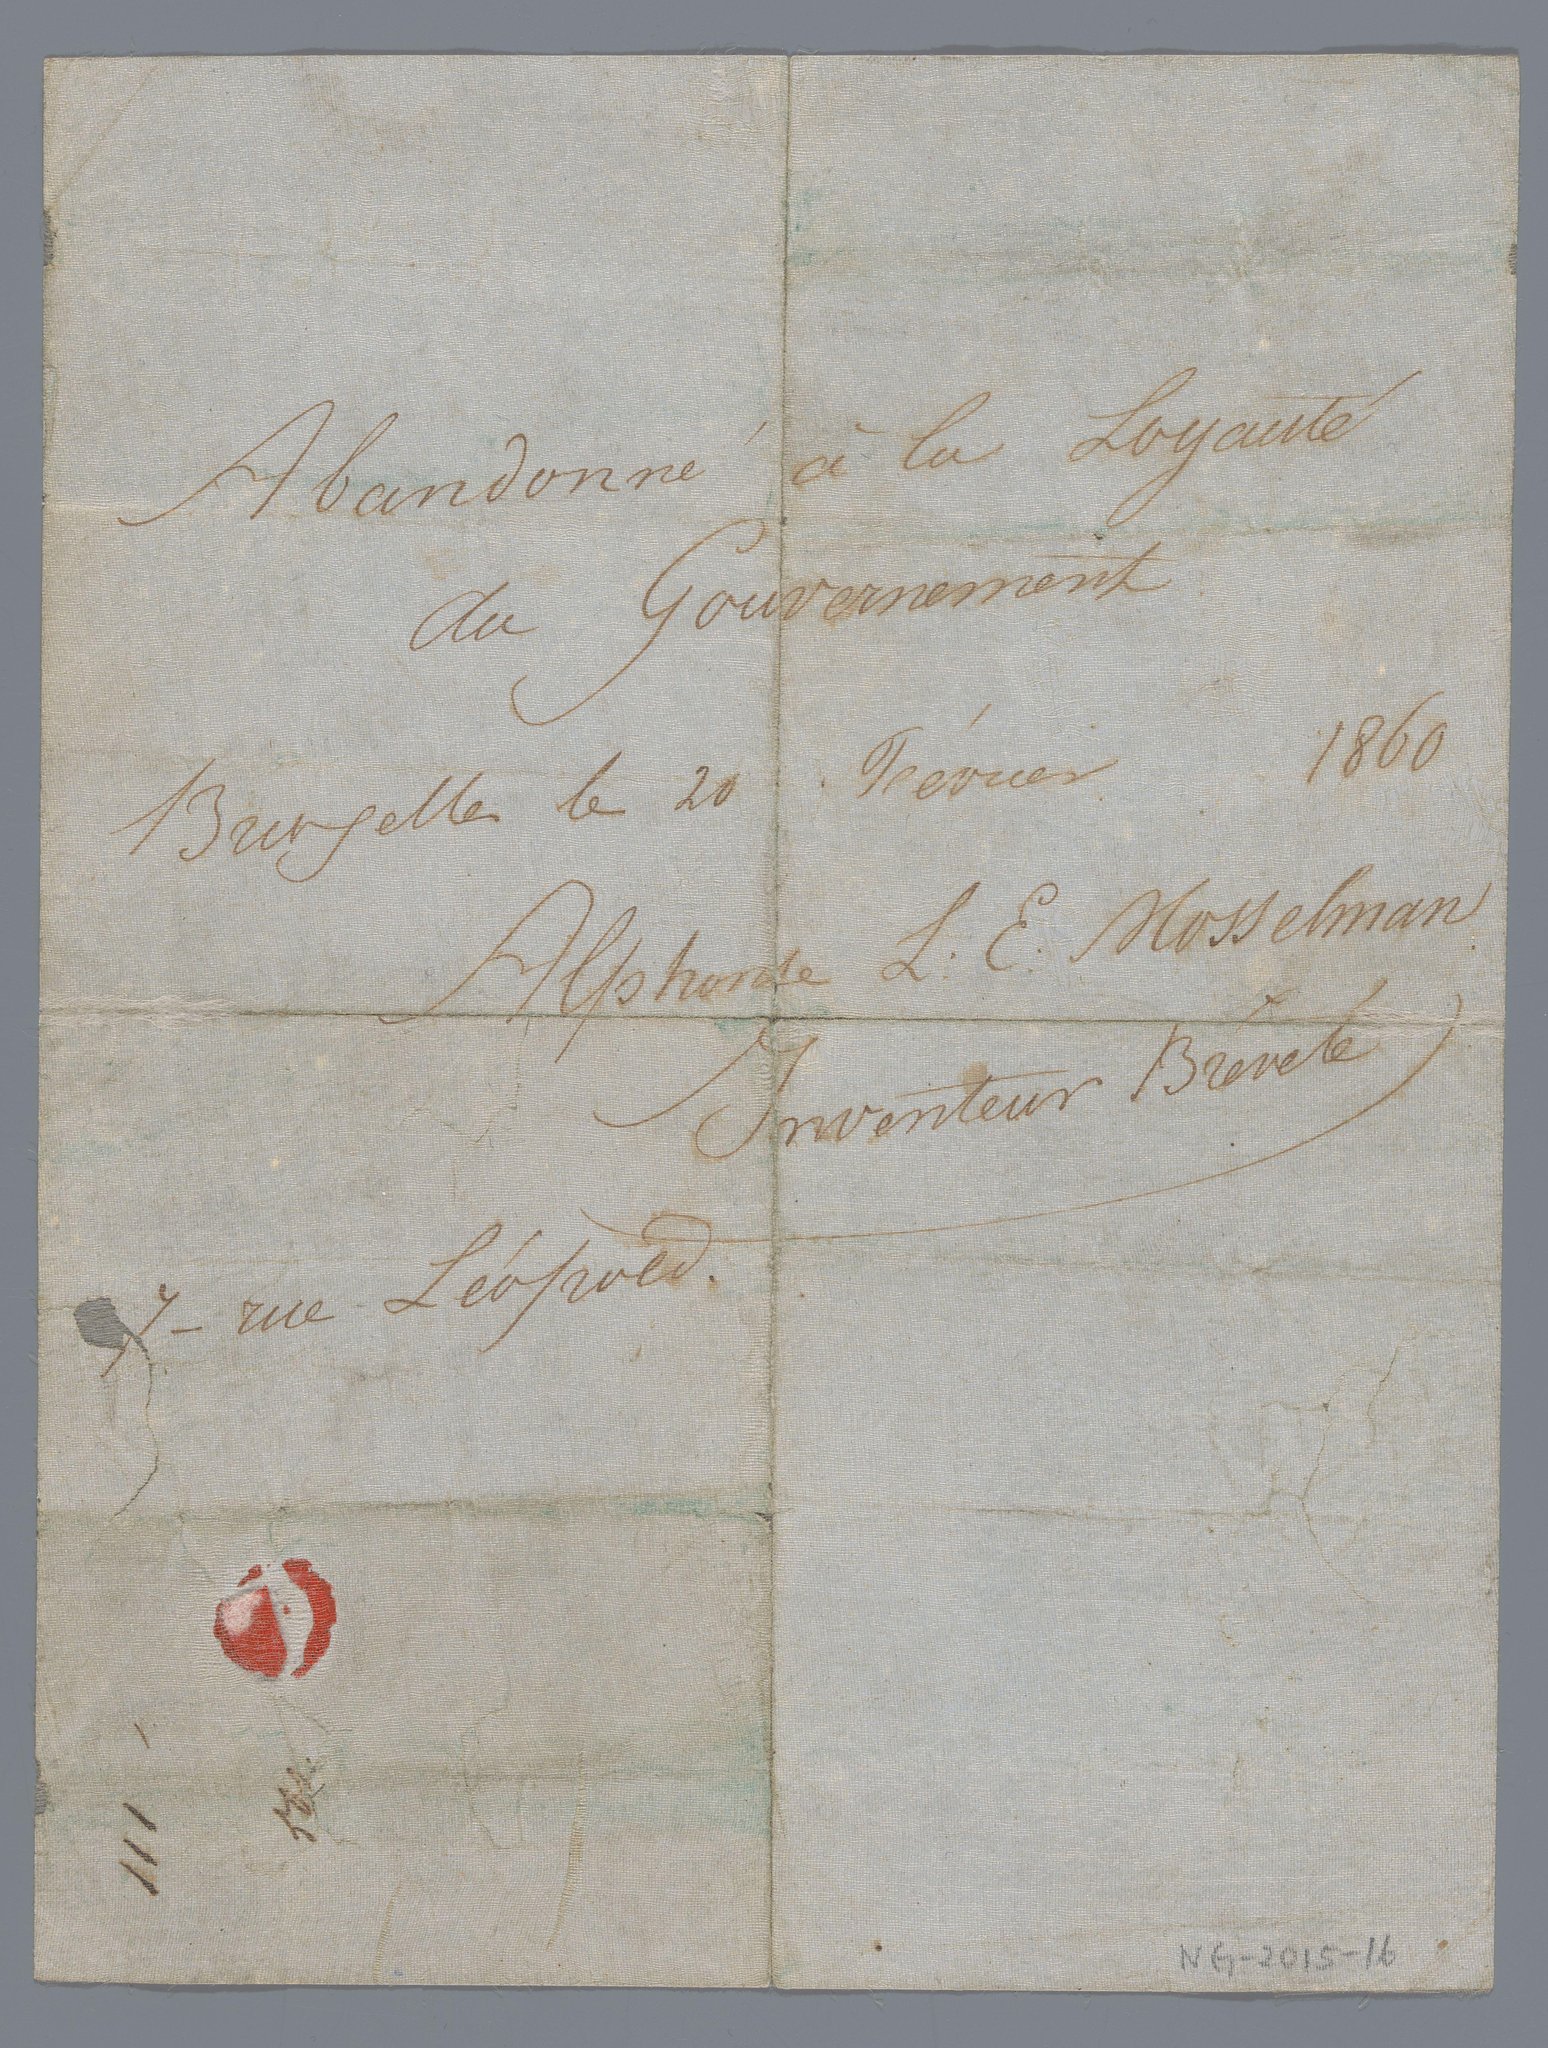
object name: print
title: Manual for a Belt to Prevent Seasickness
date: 1860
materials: paper, wax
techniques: lithograph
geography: belgium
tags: department of the navy, brussels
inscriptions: date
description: Afbeelding van een leren riem tegen zeeziekte. Op de riem vier emblemen. Onder de afbeelding een gedrukte beschrijving in het Frans van de werking van de riem. Op de achterzijde handgeschreven notities met de datum 20 februari 1860 en de naam van de uitvinder 'Alphonse L.E. Mosselman' en resten van zegellak.